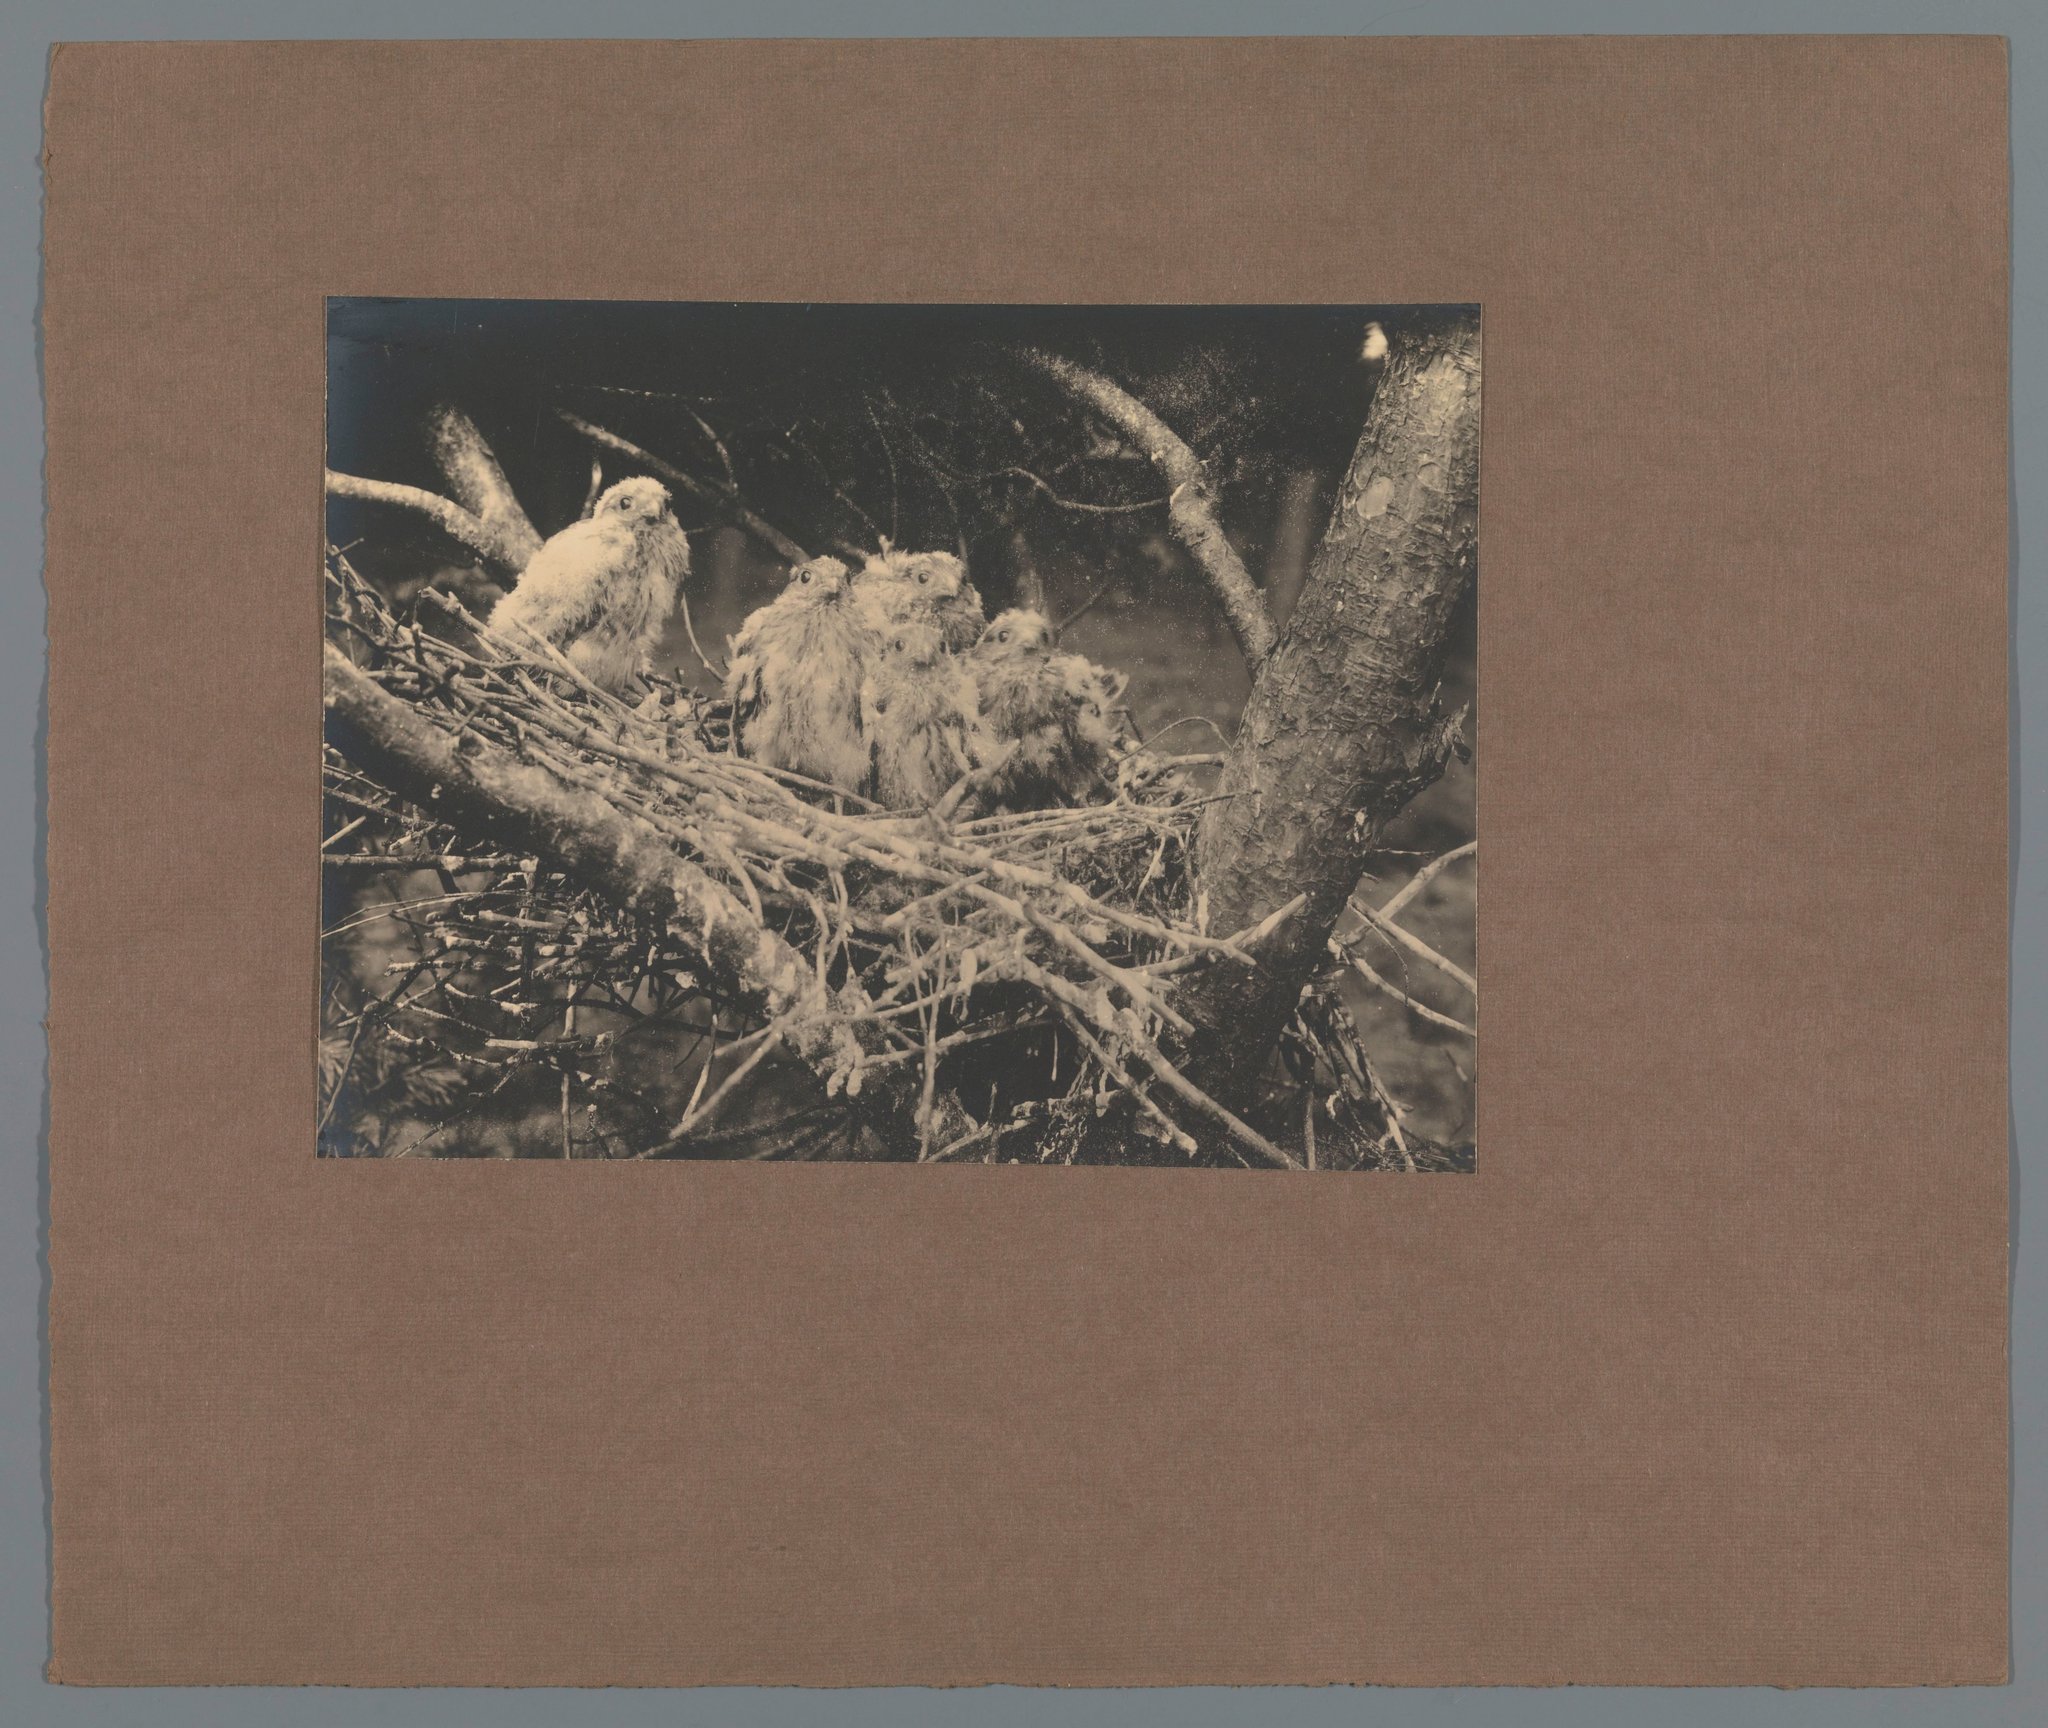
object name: photograph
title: Jonge torenvalken in een nest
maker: richard tepe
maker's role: fotograaf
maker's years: 1864-1952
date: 1900-1952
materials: paper, cardboard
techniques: gelatin silver print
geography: netherlands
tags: predatory birds: falcon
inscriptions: signature: ‘R. Tepe Apeldoorn’, inscription: ‘Horst en halfwassen/ Jongen van den Torenvalk’